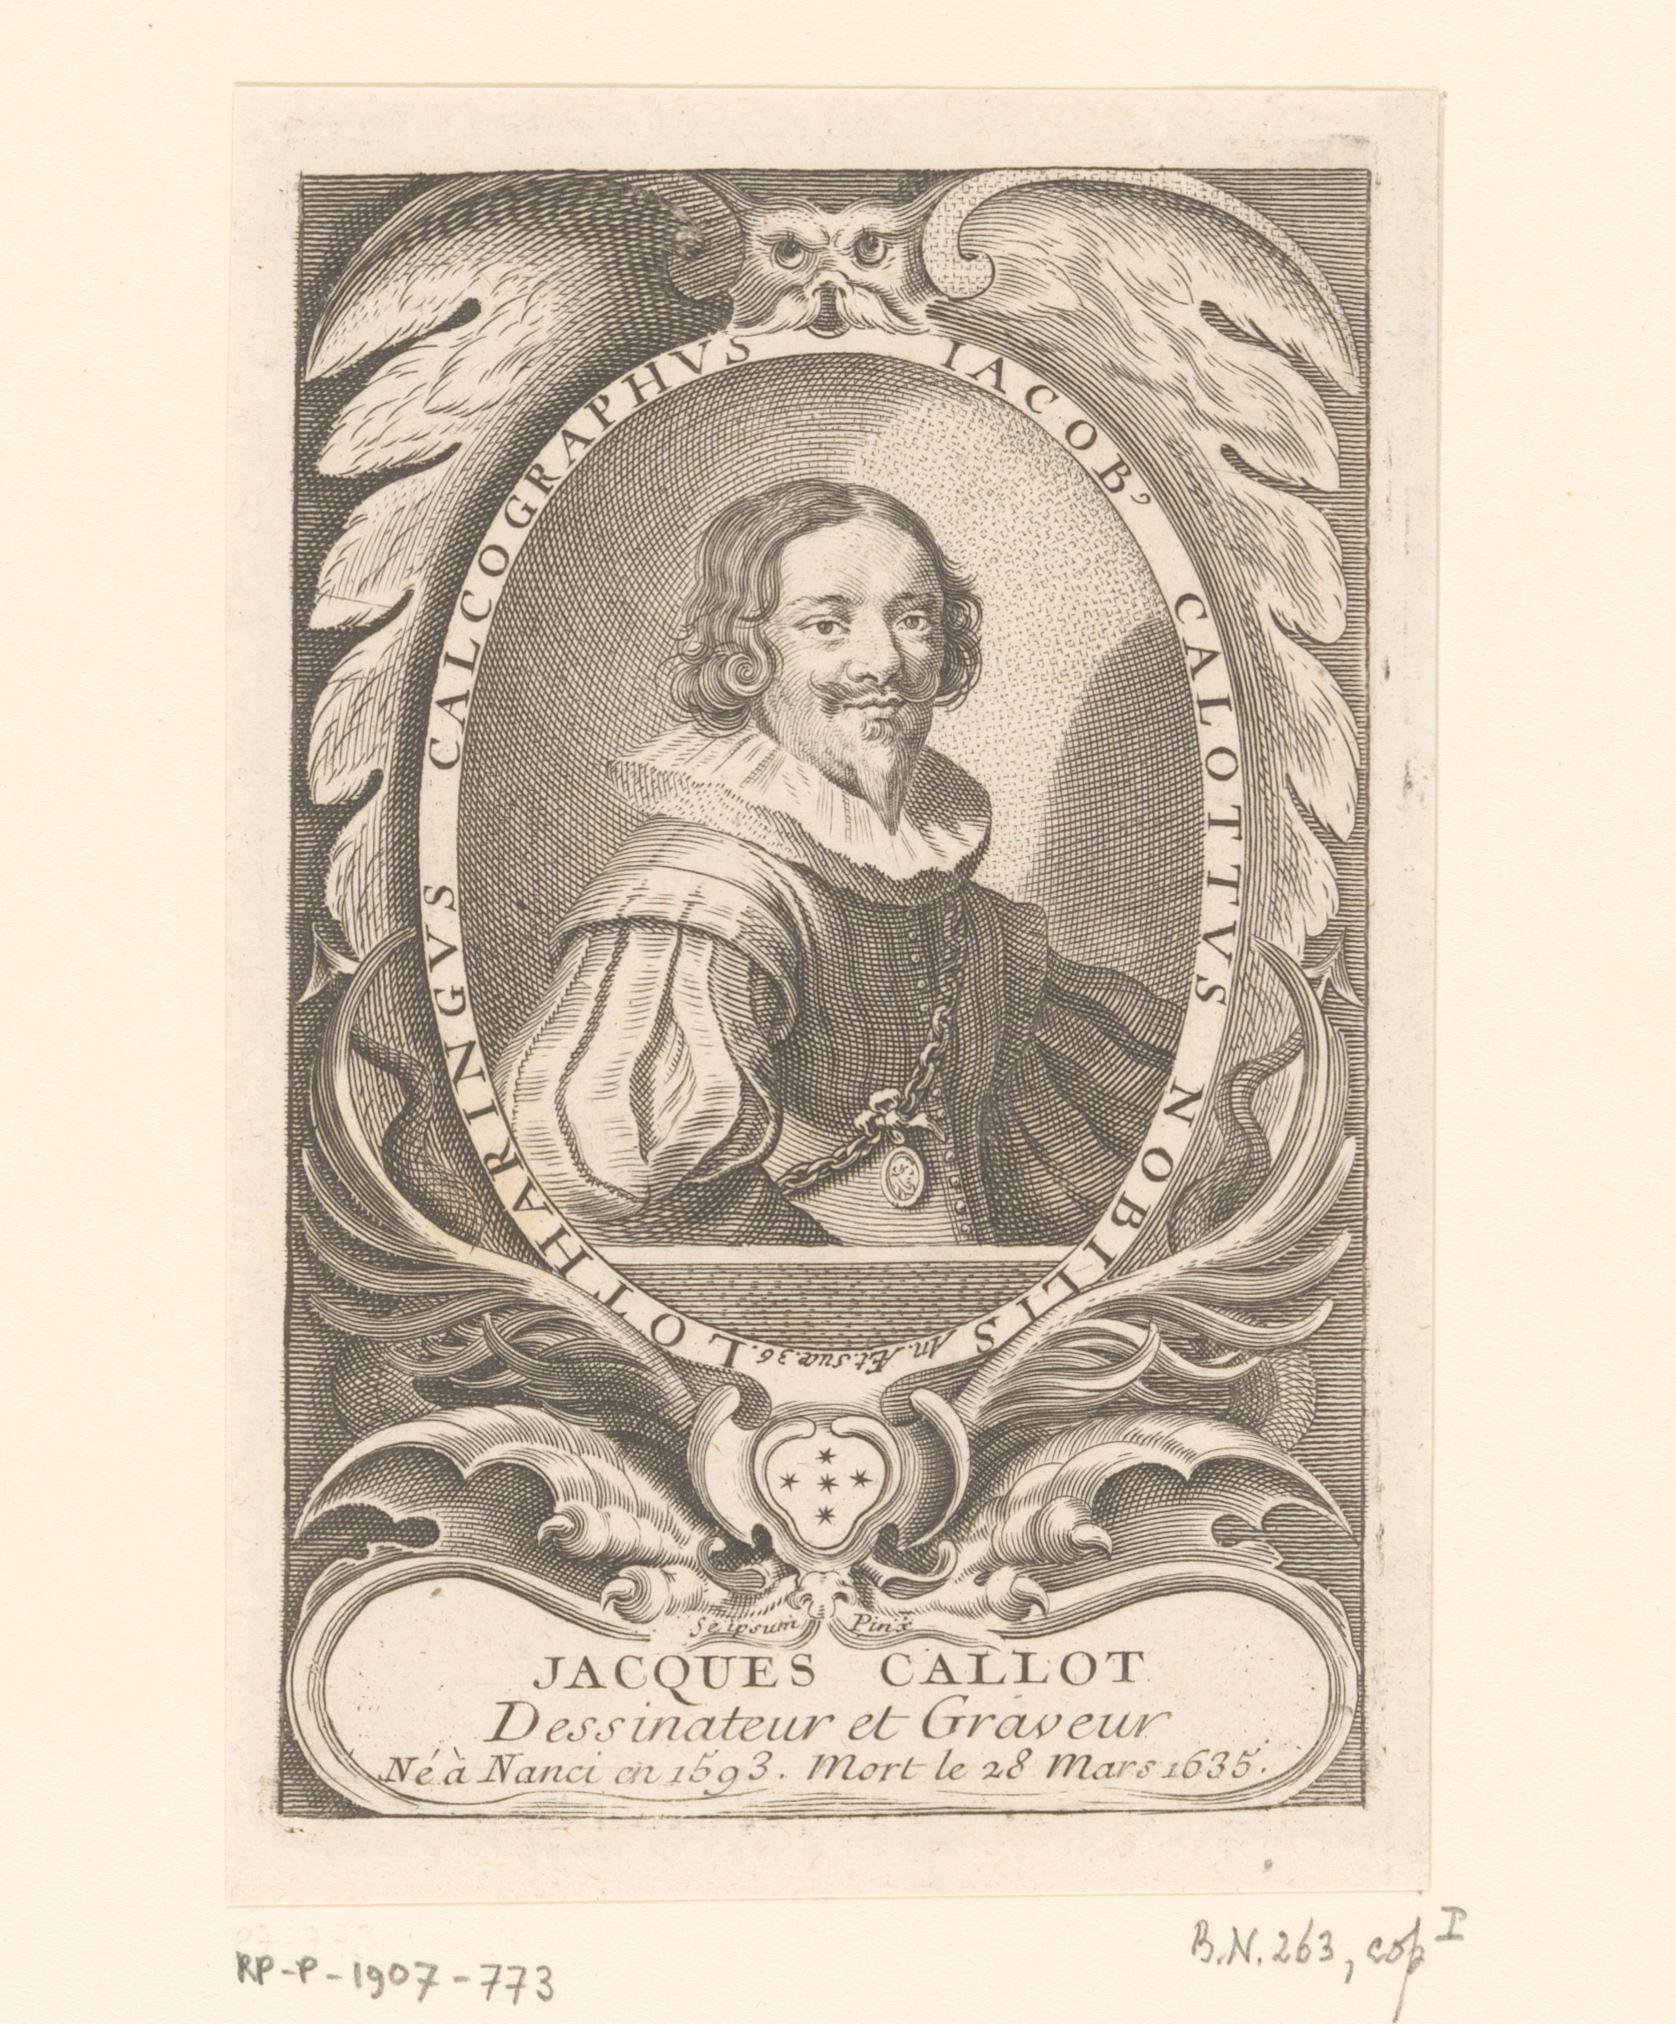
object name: print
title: Portret van Jacques Callot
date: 1697-1756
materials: paper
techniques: engraving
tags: draughtsman, jacques callot, auricular ornament, lobe style ~ ornament, historical persons, portrait, self-portrait of artist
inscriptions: collector's mark: Lugt 2228